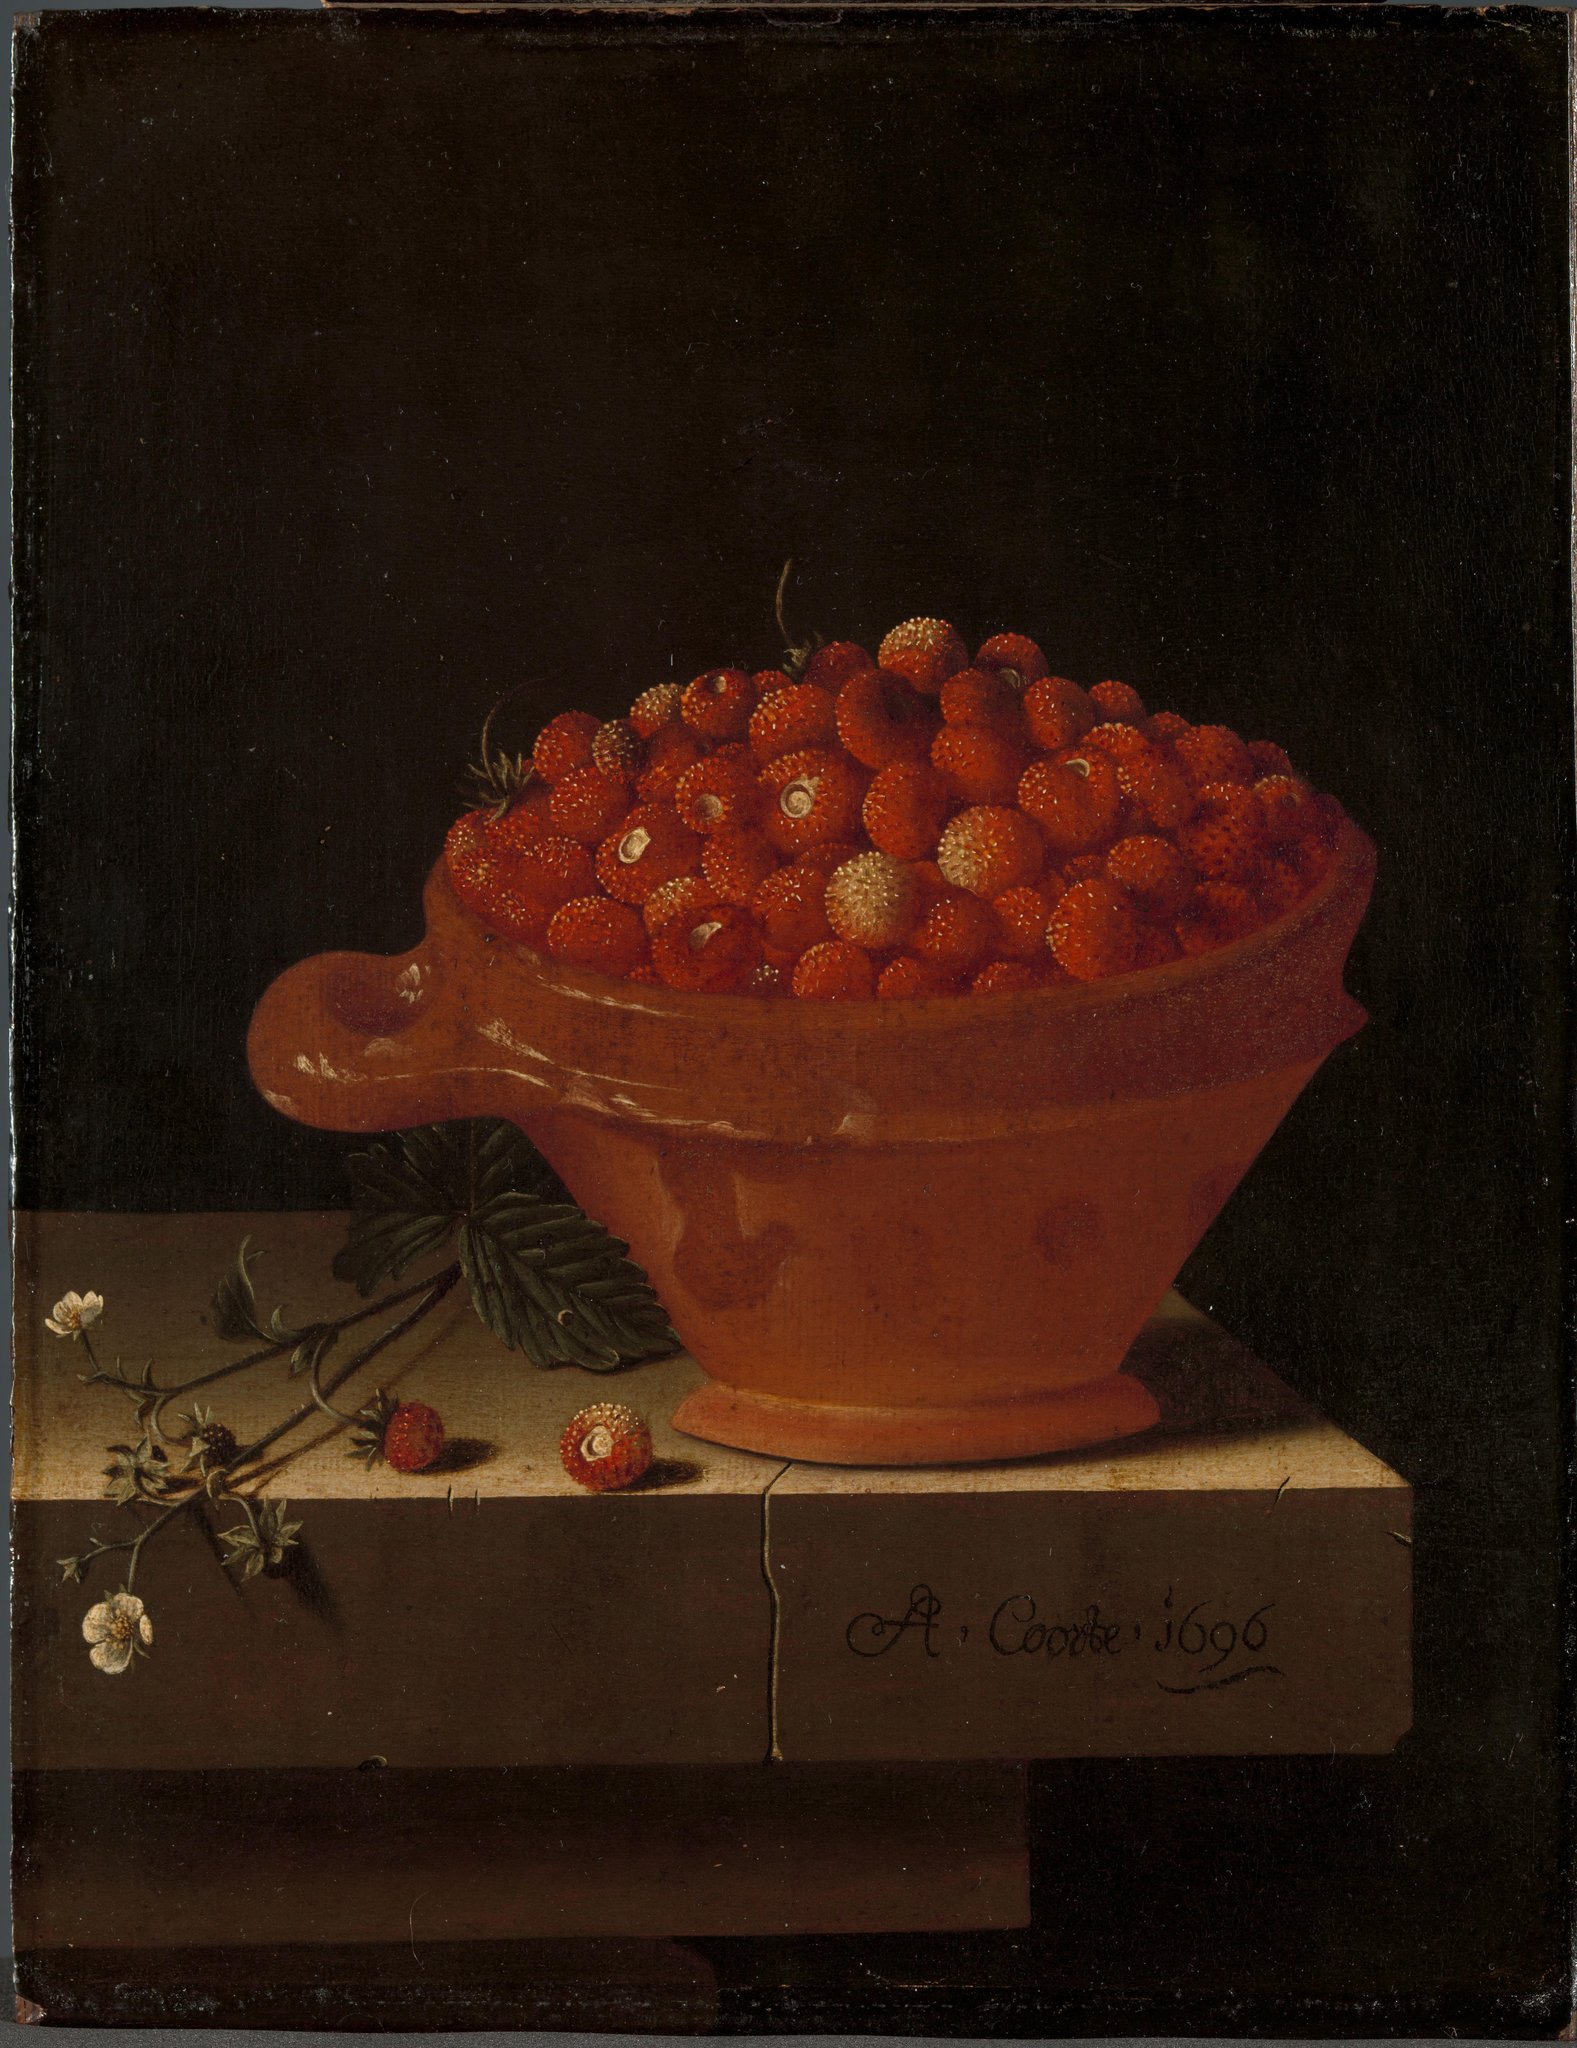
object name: painting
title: A Bowl of Strawberries on a Stone Plinth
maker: adriaen coorte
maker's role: painter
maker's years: 1665-1710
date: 1696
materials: oil, panel, paper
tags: fruits: strawberry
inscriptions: signature and date: ‘A . Coorte . 1696’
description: Coorte portrayed with the precision of a scientist. By isolating it, it is as if he wanted to get to the very essence of a peach or a gooseberry. Although these four paintings were not conceived as a series, they have formed an ensemble since the second half of the 18th century.